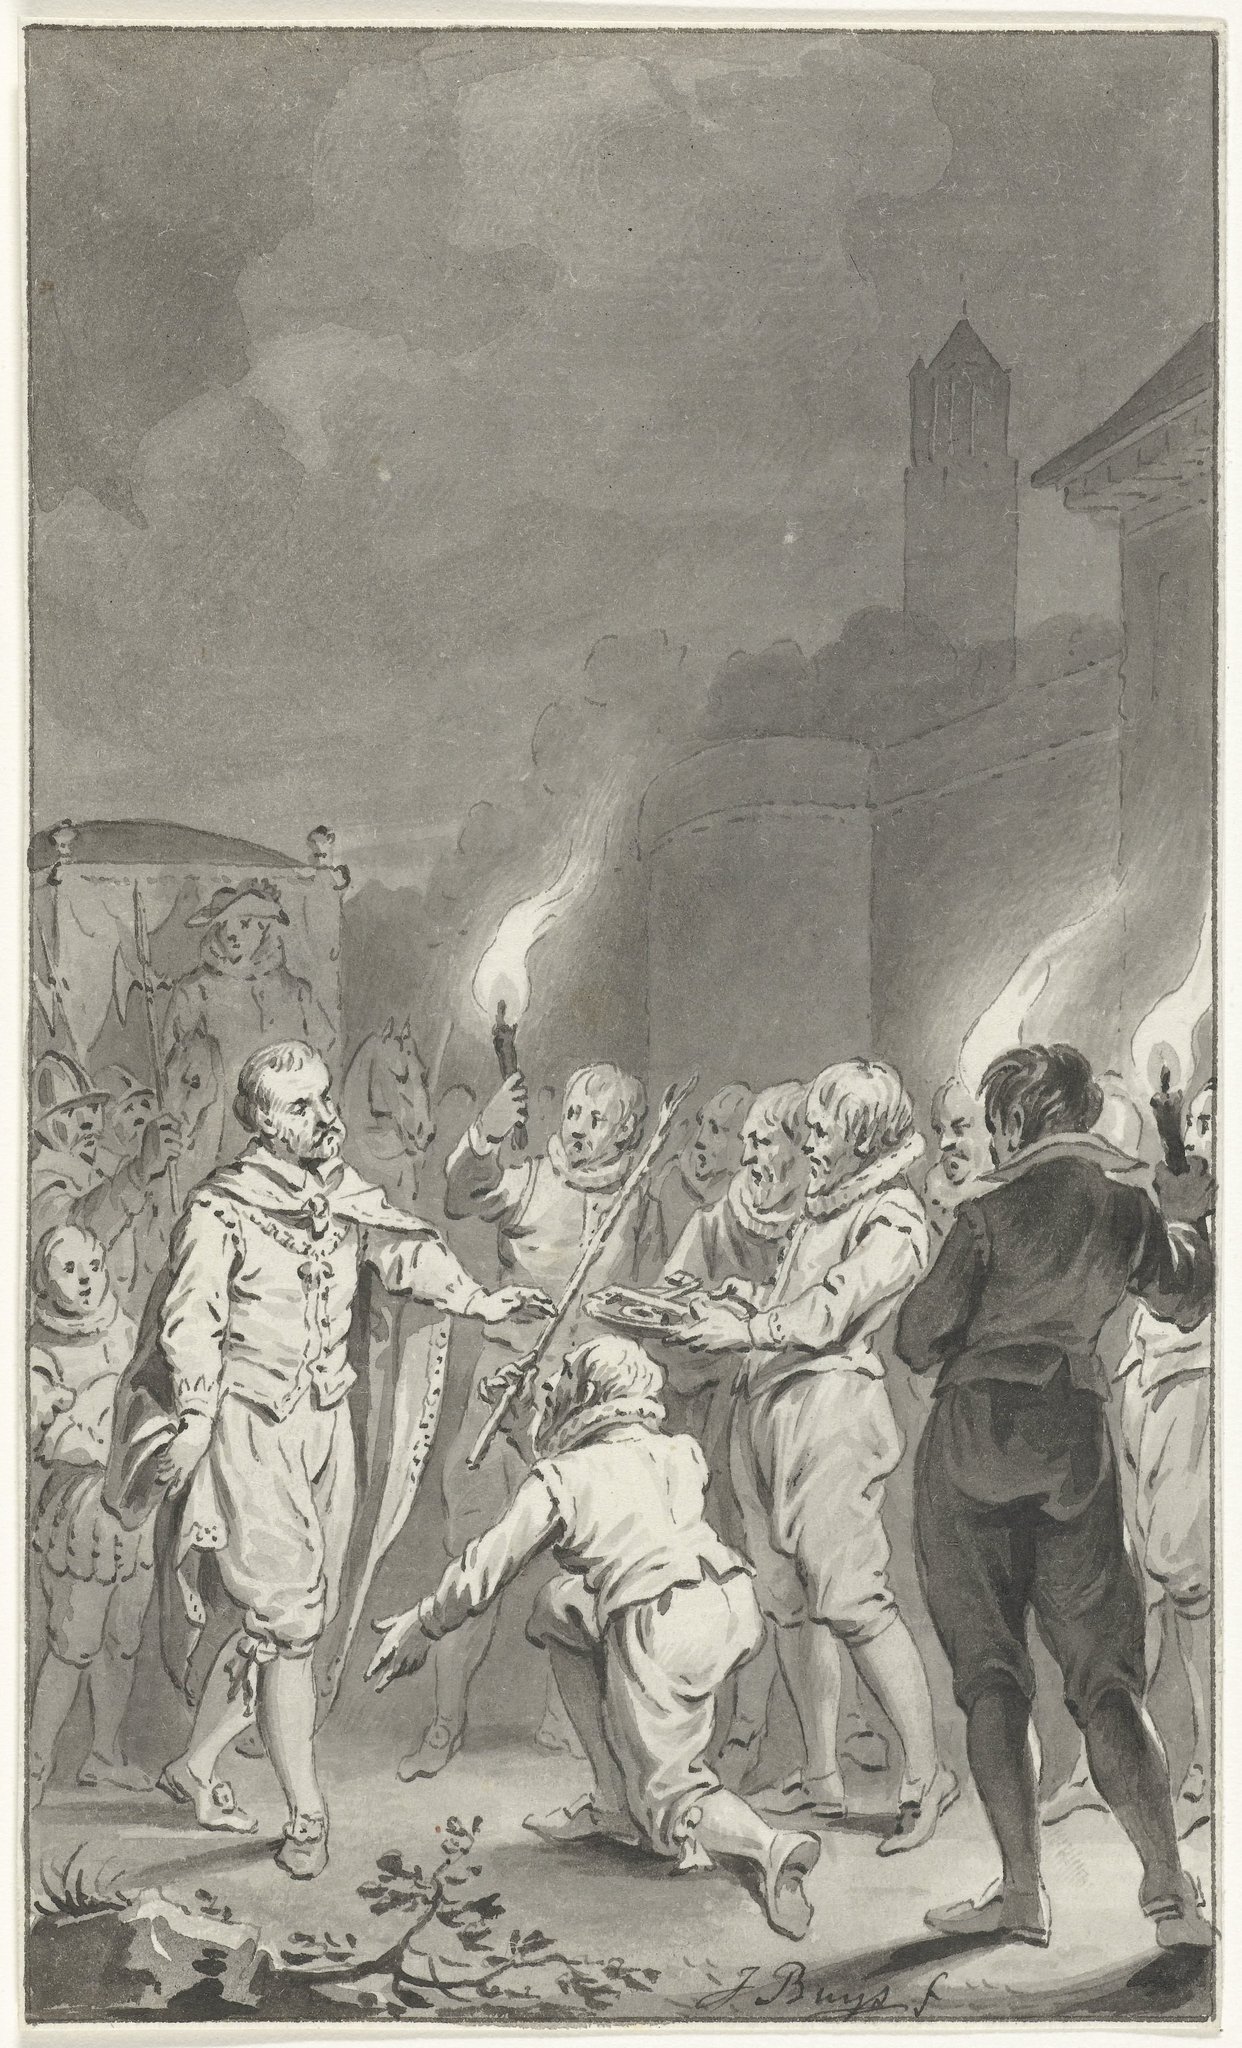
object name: history print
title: Keizer Karel V ontvangt de sleutels van de poorten en de roede van justitie van Utrecht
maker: jacobus buys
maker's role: draughtsman, print maker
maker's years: 1724-1801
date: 1787-1789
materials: ink, paper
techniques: brush, pen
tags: ghent, charles v (holy roman emperor and king of spain), symbols and allegories of law; 'legge', 'legge civile' (ripa), historical persons, surrender of keys, historical events and situations, utrecht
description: Kezier Karel V wordt te Utrecht bij licht van toortsen als Heer ingehaald en de roede van justitie en de sleutels van de stad aangeboden. Ontwerp voor een prent.